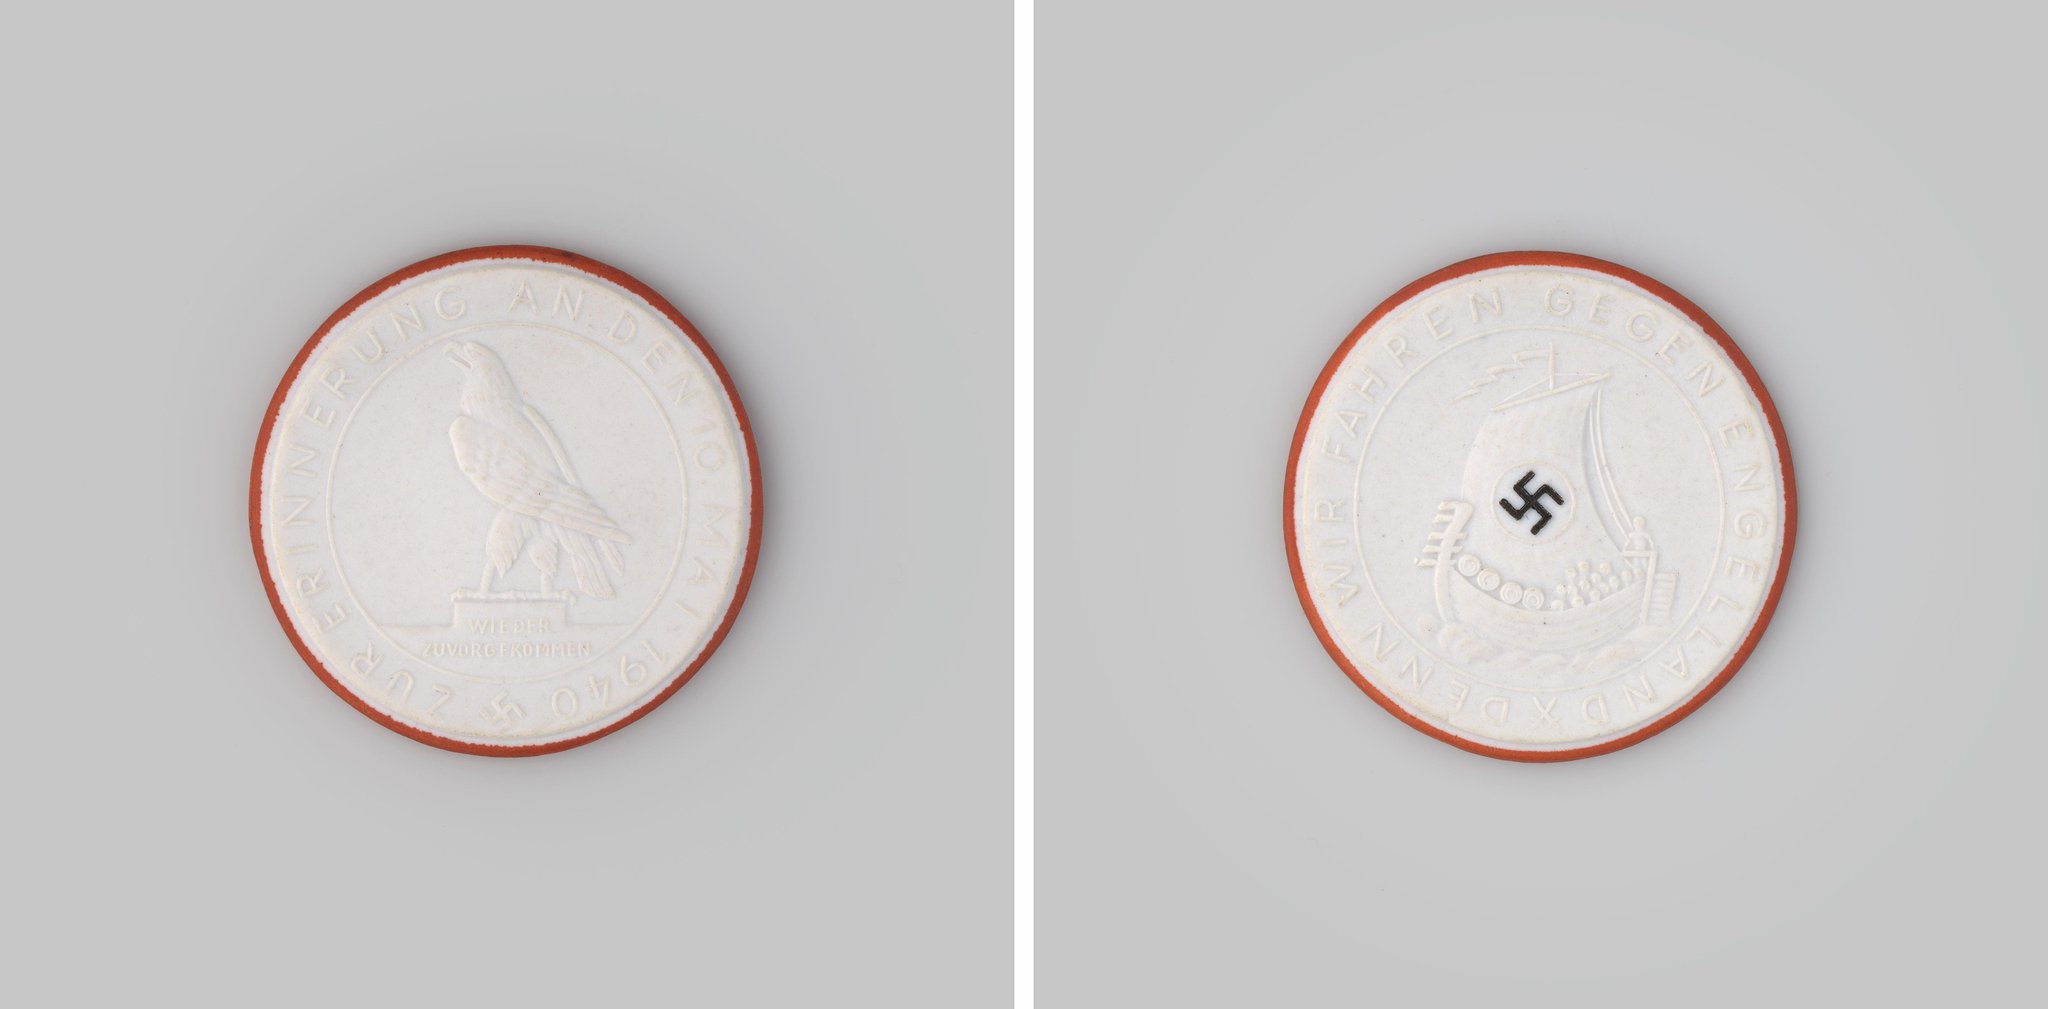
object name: medal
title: German Invasion of the Netherlands and Belgium on 10 May 1940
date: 1940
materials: paint, porcelain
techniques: striking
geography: munich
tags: duitse inval in nederland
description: The Rijksmuseum’s medal collection, boasting some 12,500 objects, is almost a century and a half old. The museum continues to expand its collection with special medals, which are either purchased, donated, or given on loan. On display here are a number of the most extraordinary acquisitions of recent years. These are honorary and commemorative medals. Several are unique and came from the descendants of the individuals who once received them.